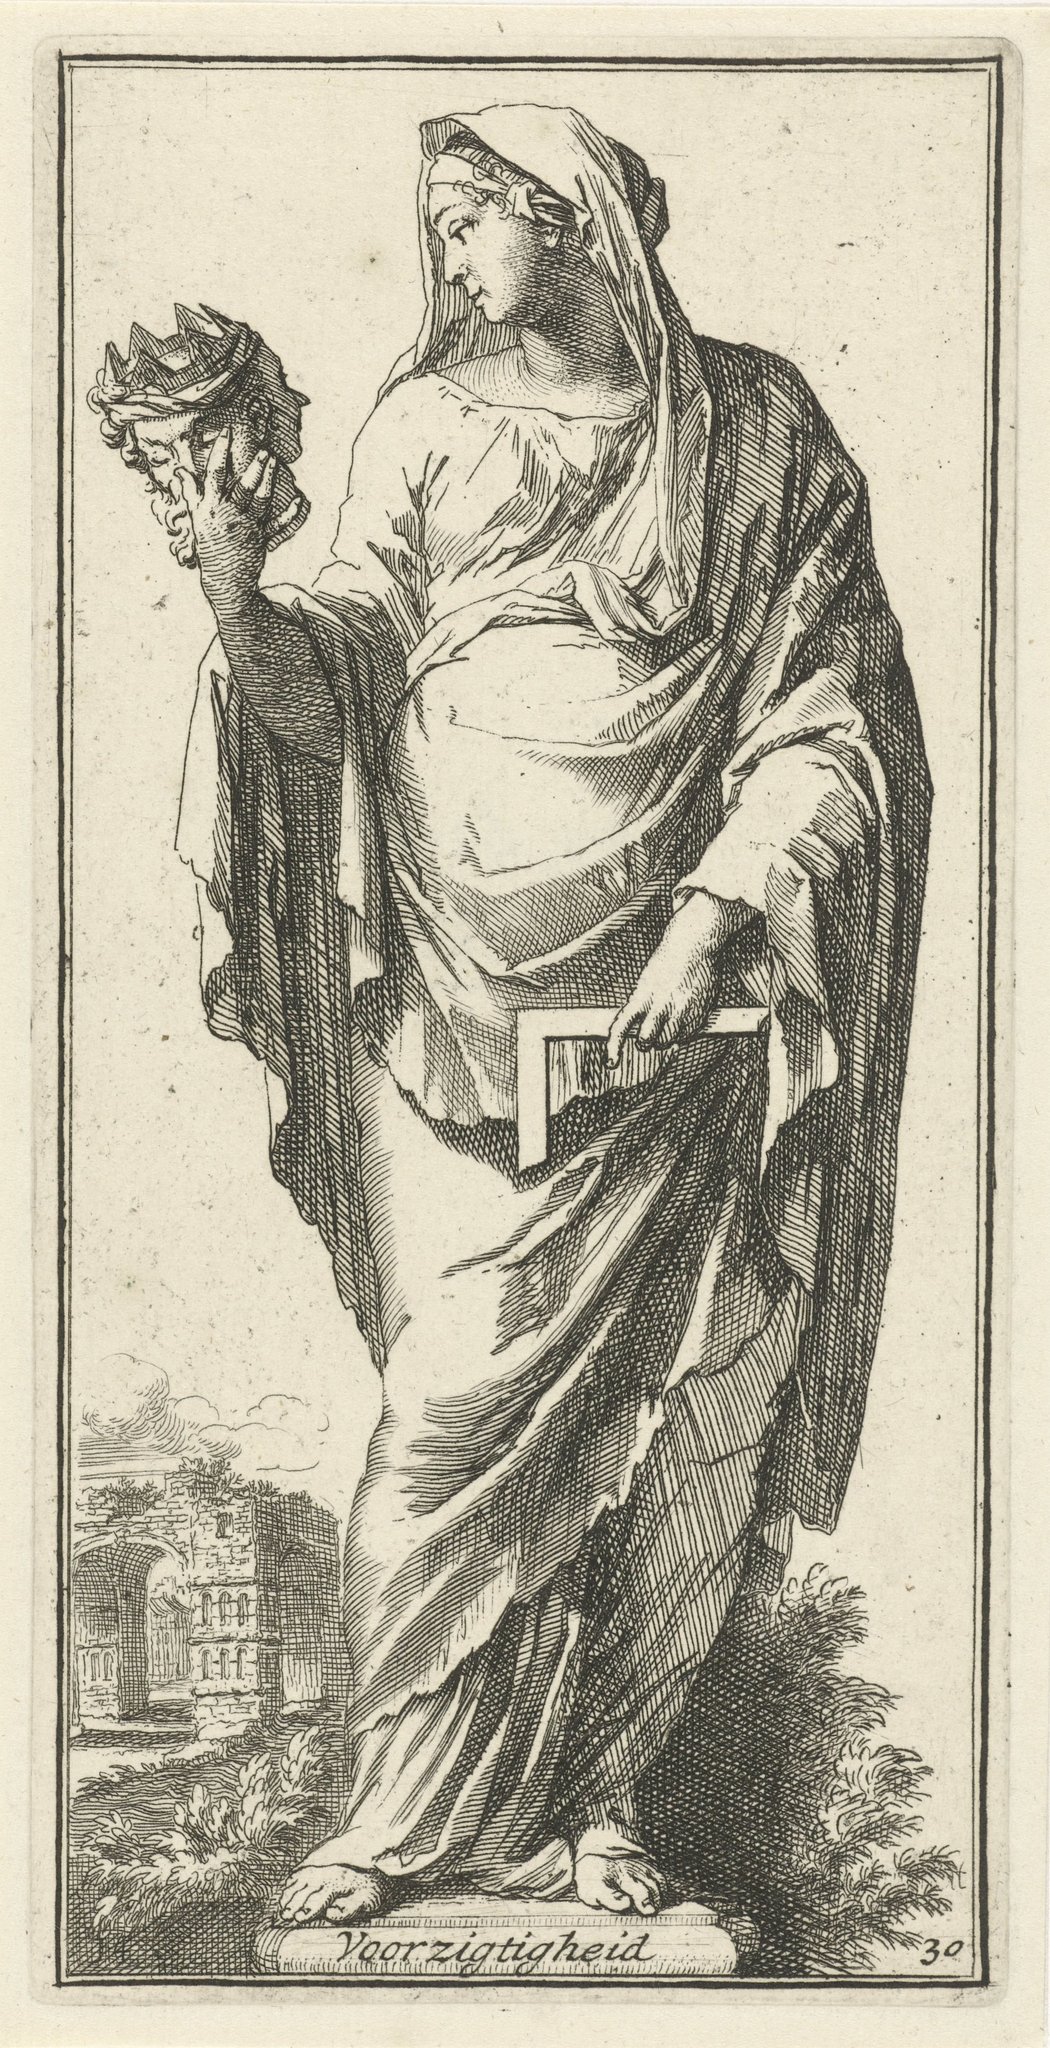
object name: print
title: Voorzigtigheid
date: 1710-1719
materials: paper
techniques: engraving, etching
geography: amsterdam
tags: mask, precaution, carefulness, diligence; 'diligenza' (ripa), square (drawing-instrument)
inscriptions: collector's mark: Lugt 2228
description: Een vrouwfiguur als personificatie van de voorzichtigheid, met in haar handen een winkelhaak en een masker met twee gezichten. Prent uit een serie van 41 zinnebeelden.